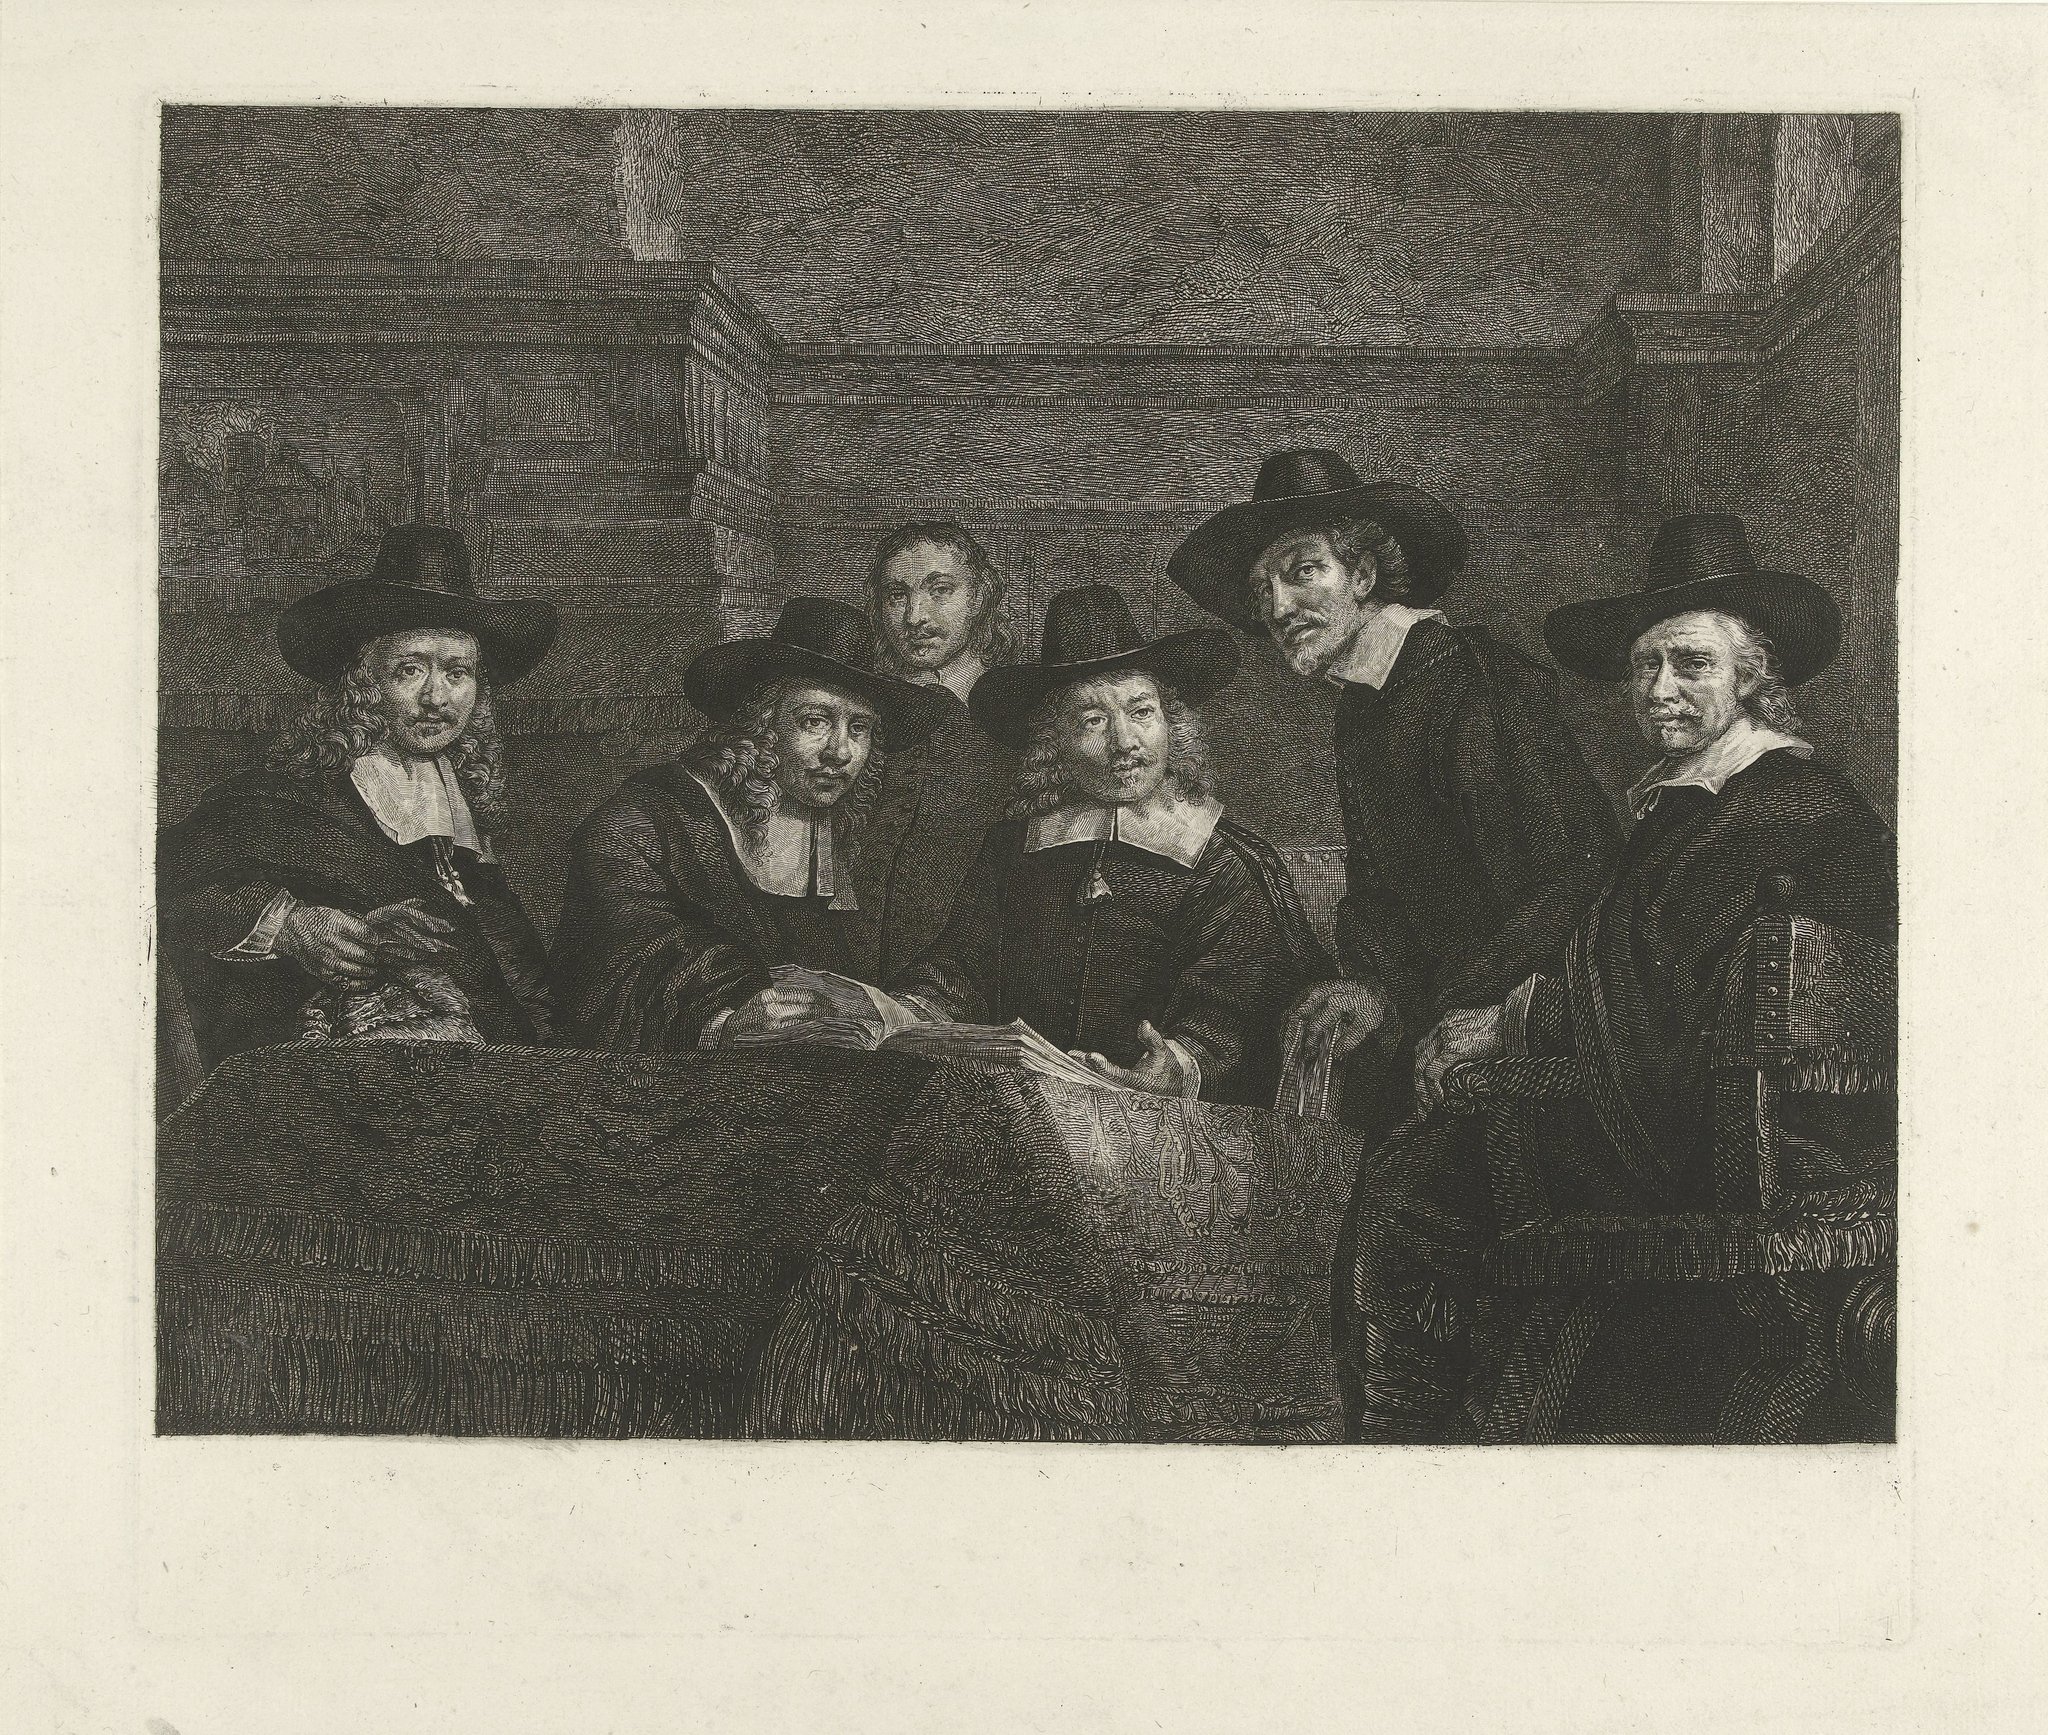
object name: print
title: De Staalmeesters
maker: johannes pieter de frey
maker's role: draughtsman, print maker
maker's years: 1770-1834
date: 1799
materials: paper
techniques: etching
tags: control of quality, amsterdam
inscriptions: collector's mark: Lugt 12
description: De Staalmeesters: het college van staalmeesters of waardijns van het Amsterdamse lakenbereidersgilde, bijeen rond een tafel waarop een Perzisch kleed ligt, op tafel het opengeslagen stalenboek. Voorgesteld zijn van links naar rechts: Jochem de Neve (1629-81), Aernout van der Mye (ca. 1625-81), de knecht Frans Hendricksz Bel (1629-1701), Willem van Doeyenburg (ca. 1616-87), Volckert Jansz (1605/10-81), Jacob van Loon (1595-1674). Links boven de haard een schilderij met een brandend baken.